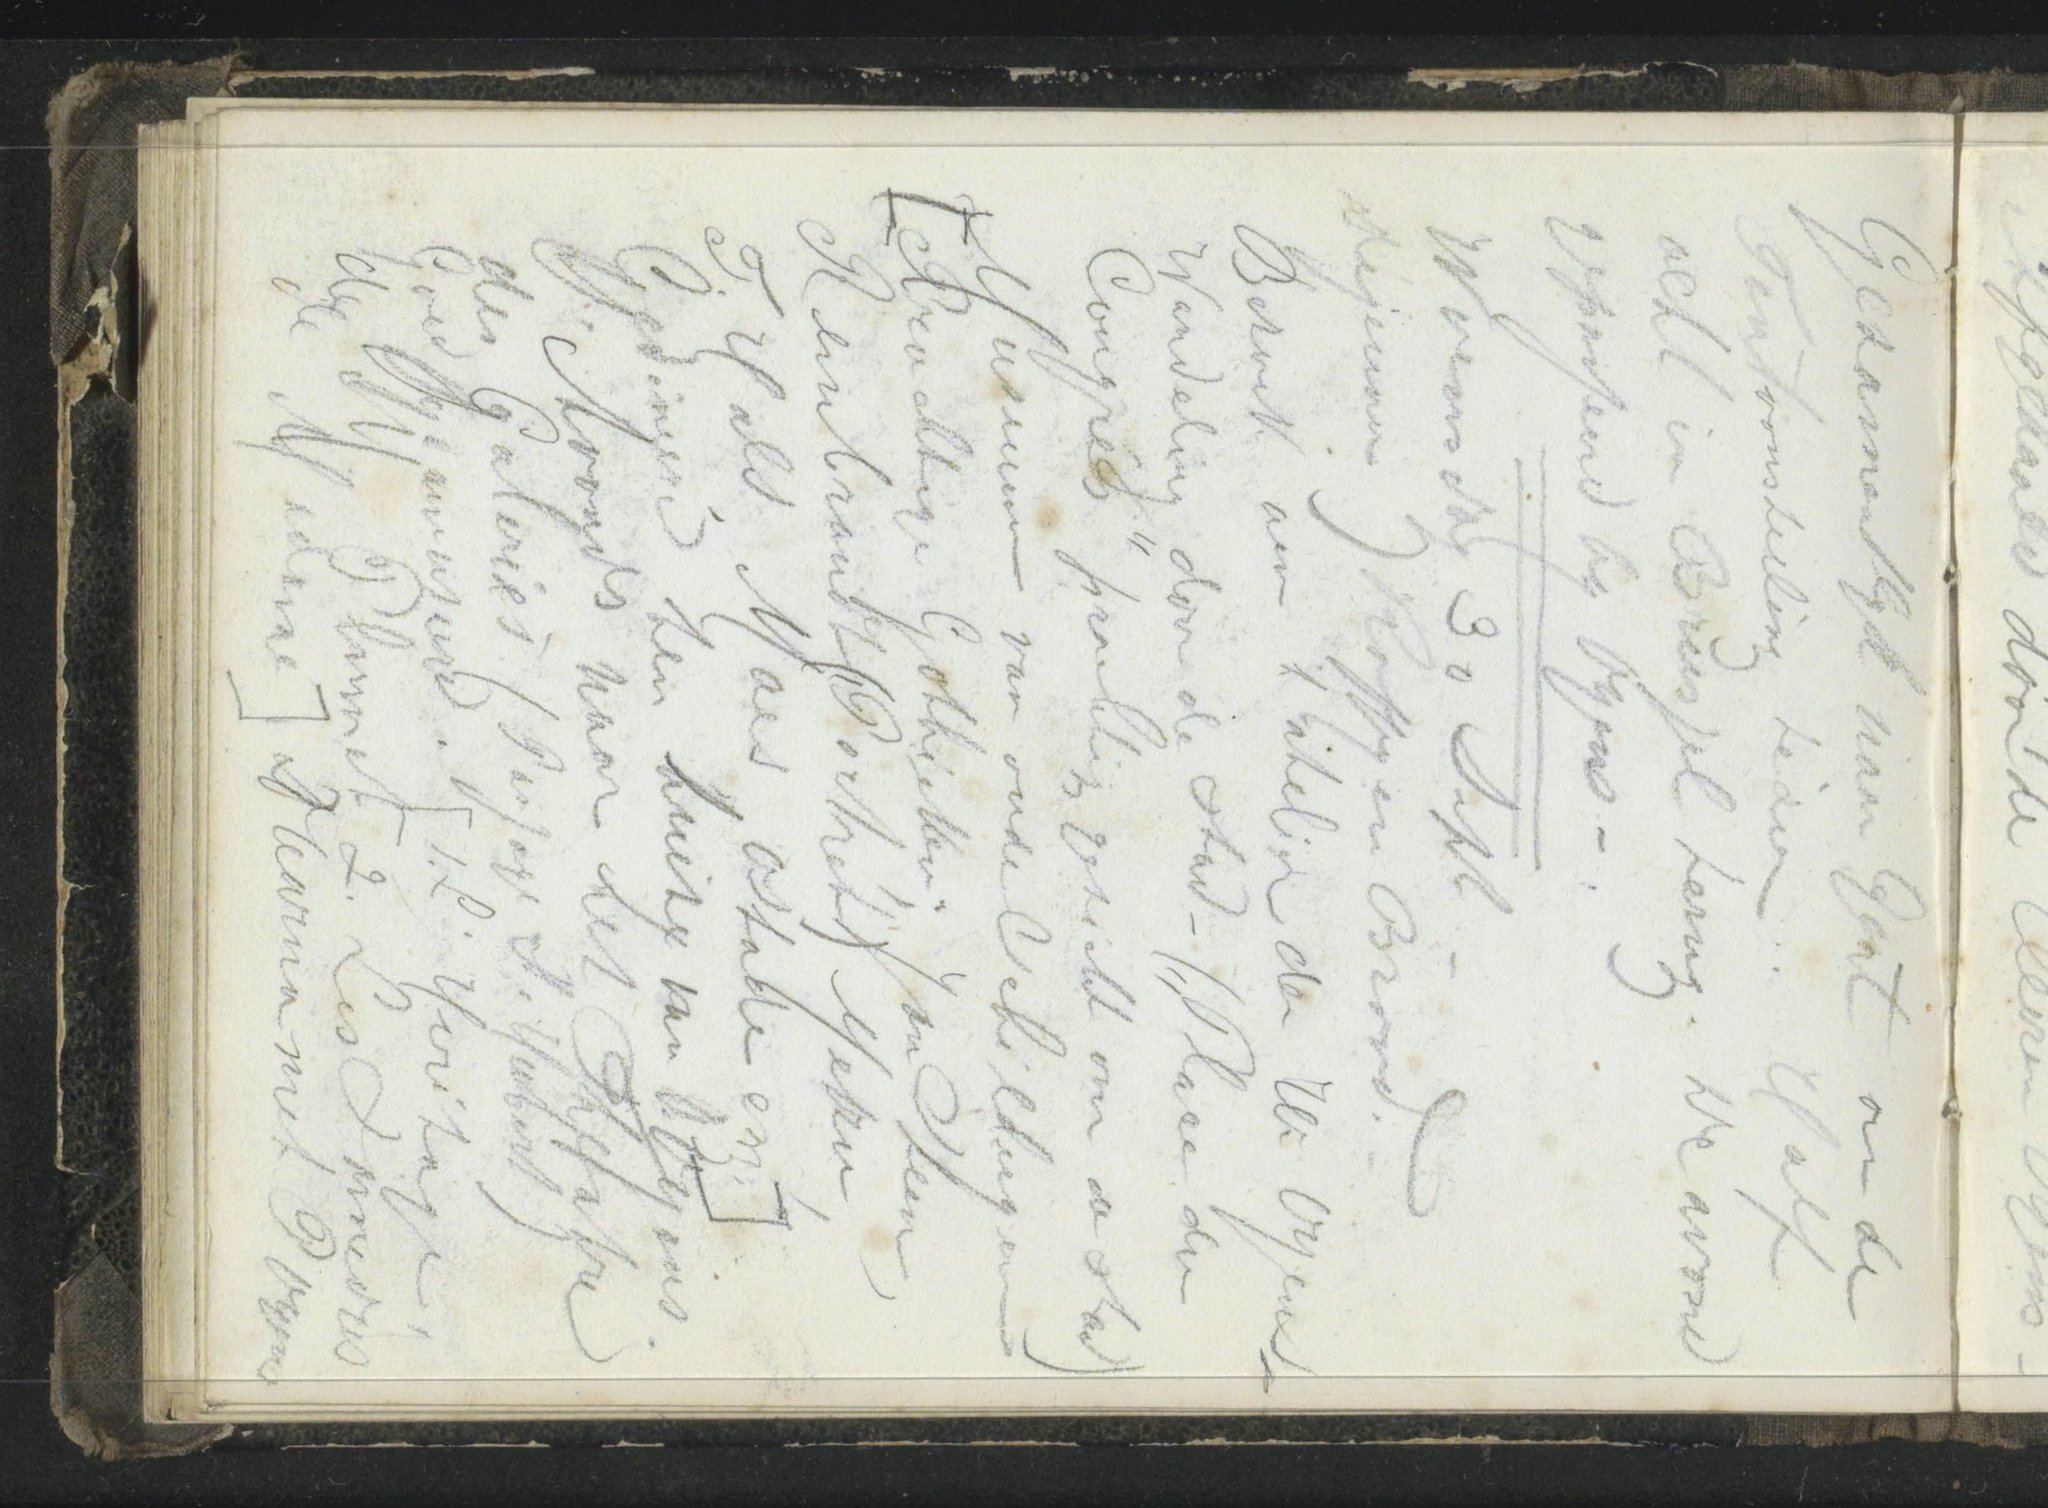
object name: sketchbook leaf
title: Notities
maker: theo hanrath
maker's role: draughtsman, painter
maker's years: 1853-1883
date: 1879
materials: paper, pencil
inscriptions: date and inscription: ‘[...] Woensdag 30 Sept [...]’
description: Blad 26 verso uit een schetsboek met 27 bladen.